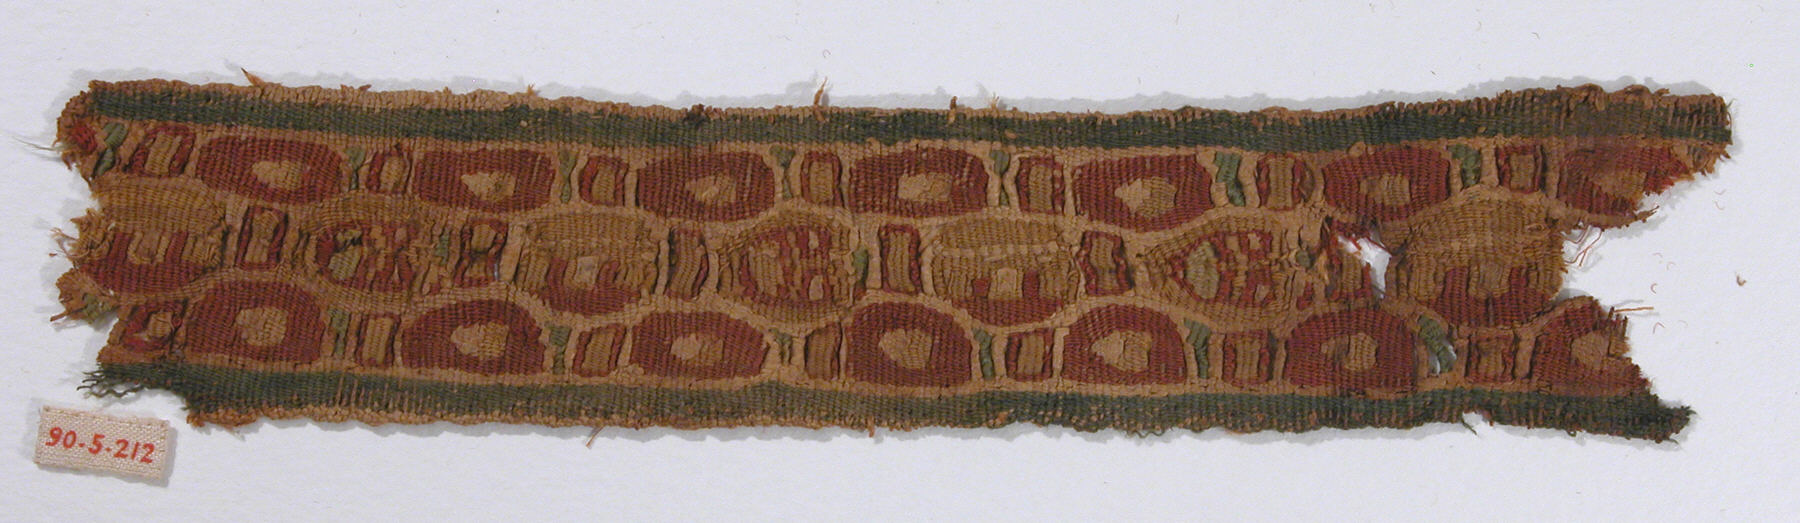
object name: textile fragment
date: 501-700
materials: linen, wool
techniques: weave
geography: egypt